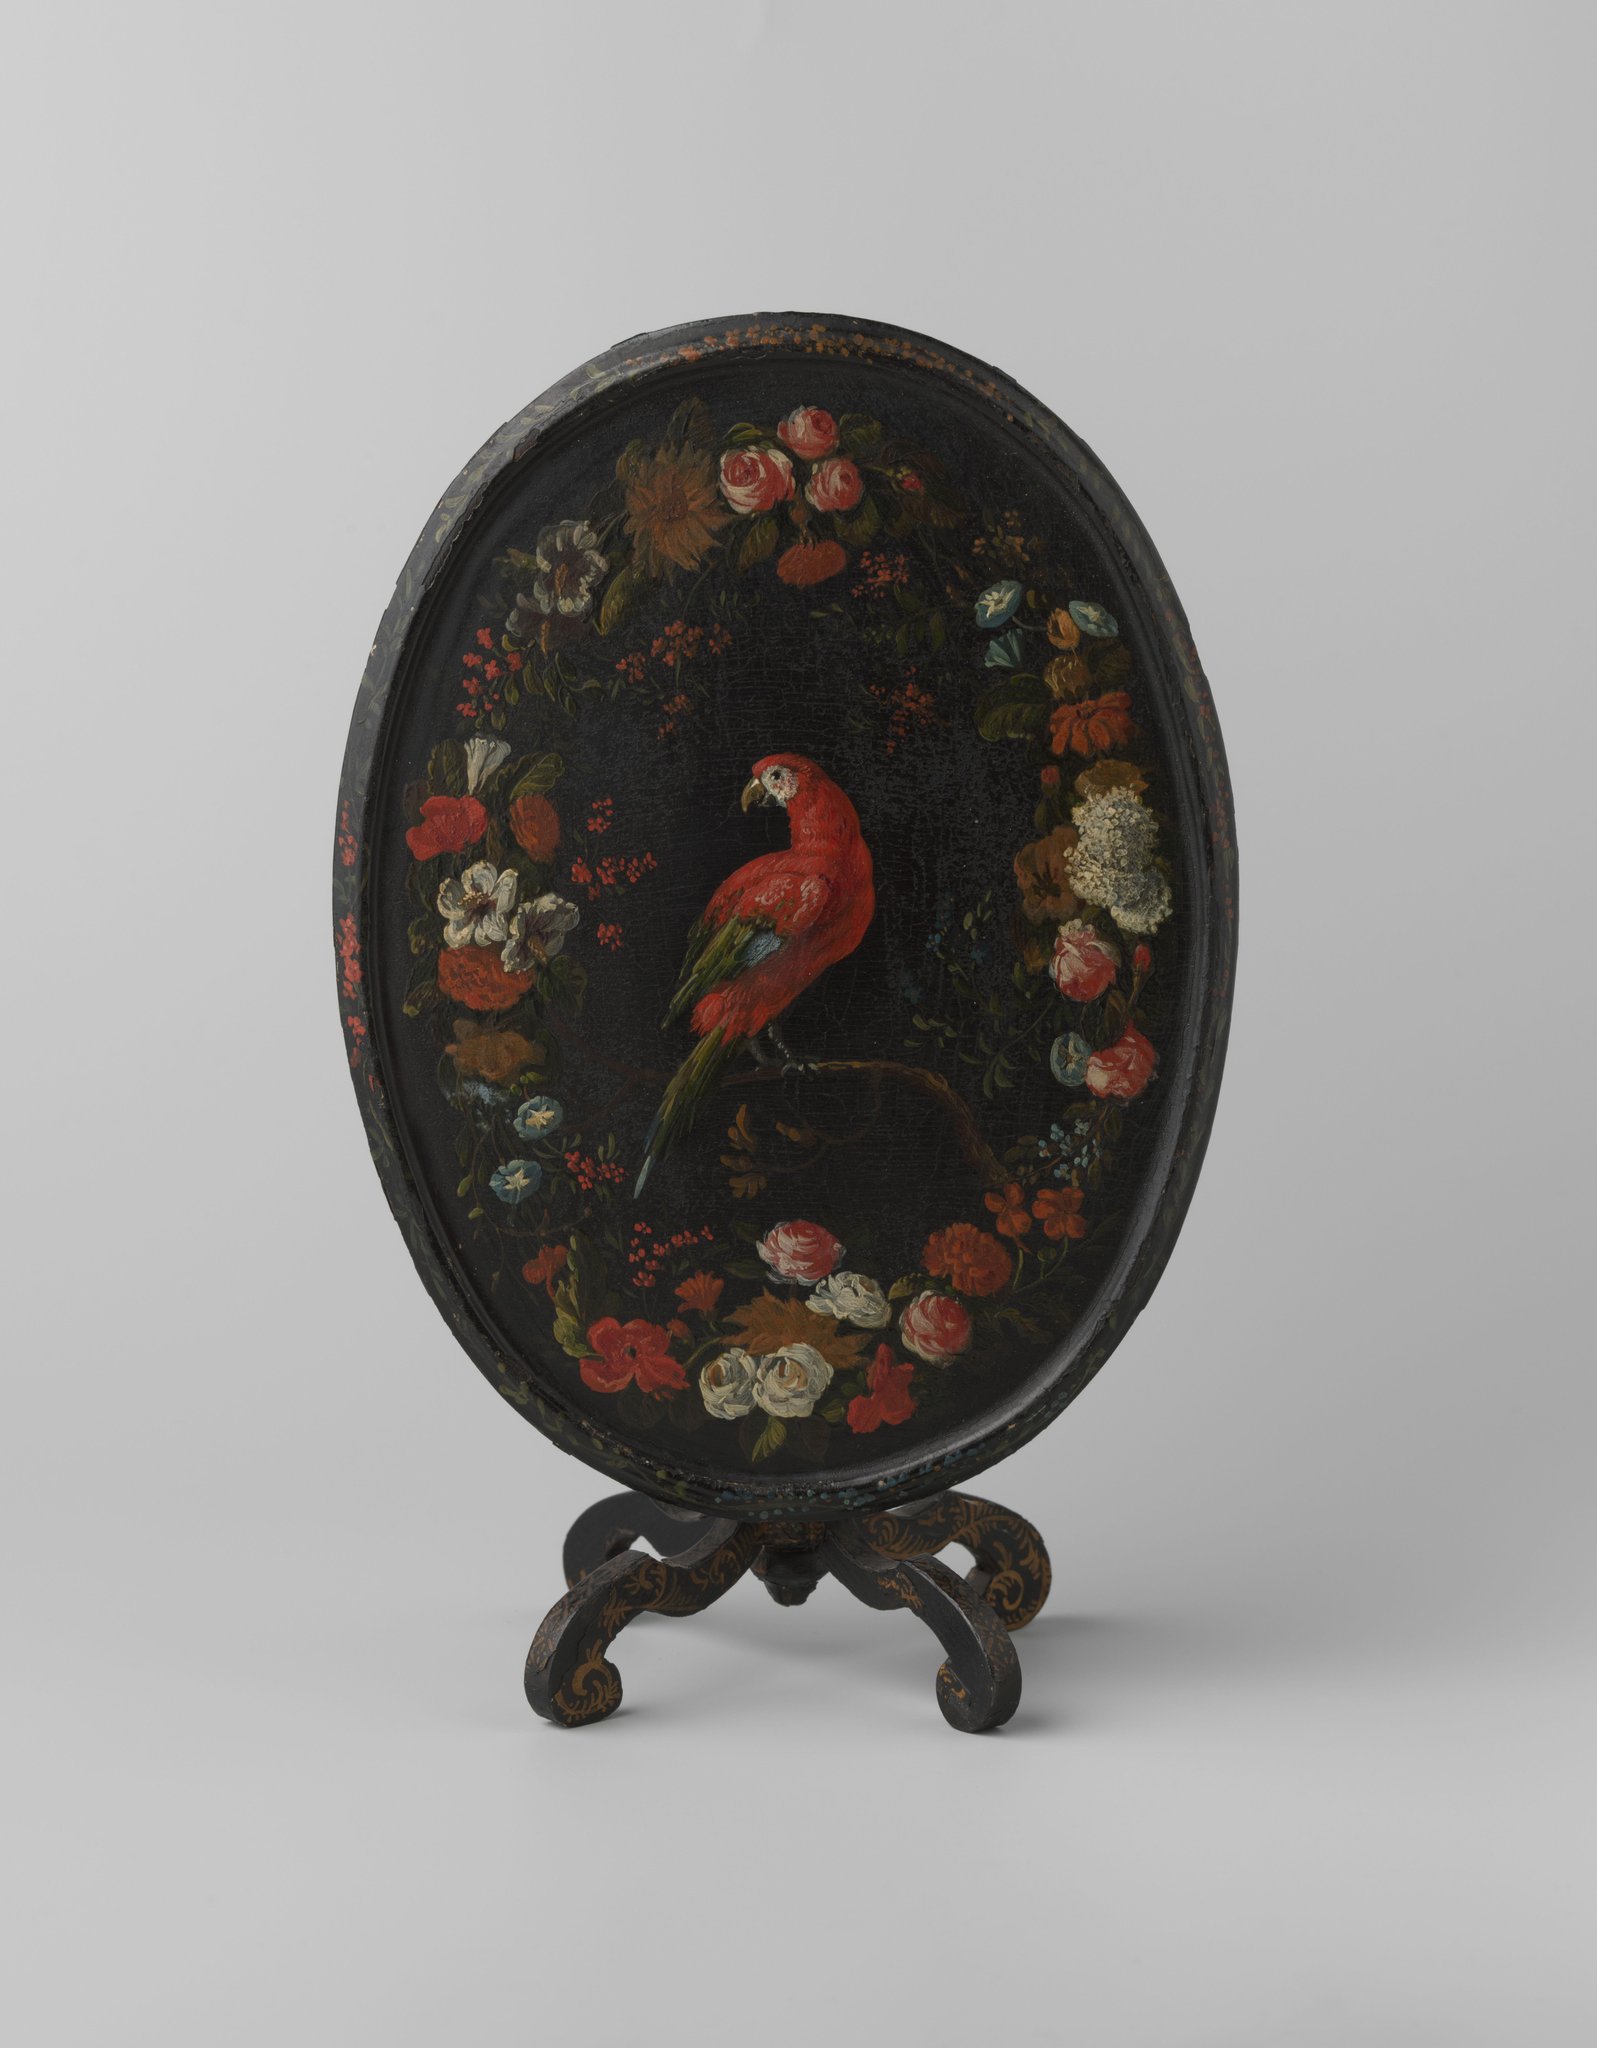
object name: miniature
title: Klaptafel vervaardigd van een zwart gelakte without, met een opklapbaar blad. Blad beschilderd.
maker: willem hendrik wilhelmus van royen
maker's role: draughtsman, painter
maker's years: 1672-1742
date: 1690-1710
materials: wood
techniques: lacquer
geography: amsterdam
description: Klaptafel, vervaardigd van een zwart gelakte withoutsoort, met een ovaal opklapbaar blad. Het blad is beschilderd met een veelkleurige bloemkrans rond een papegaai, gezeten op een tak; de opstaande rand is versierd met blaadjes en bloemetjes, even eens veelkleurige, alles op zwarte achtergrond. Het blad scharniert aan de achterzijde op een klein vierkant blad en kan met een eveneens zwart meegelakt vergrendeling daarop vastgeklikt wordn. De pootjes balustervormig, eindigend in een knop, en rust op vier straalsgewijs geknikte S-vormige voluten, beschilderd met gouden ornamenten (geometrisch en ranken) op zwarte achtergrond (imitatie lakwerk).